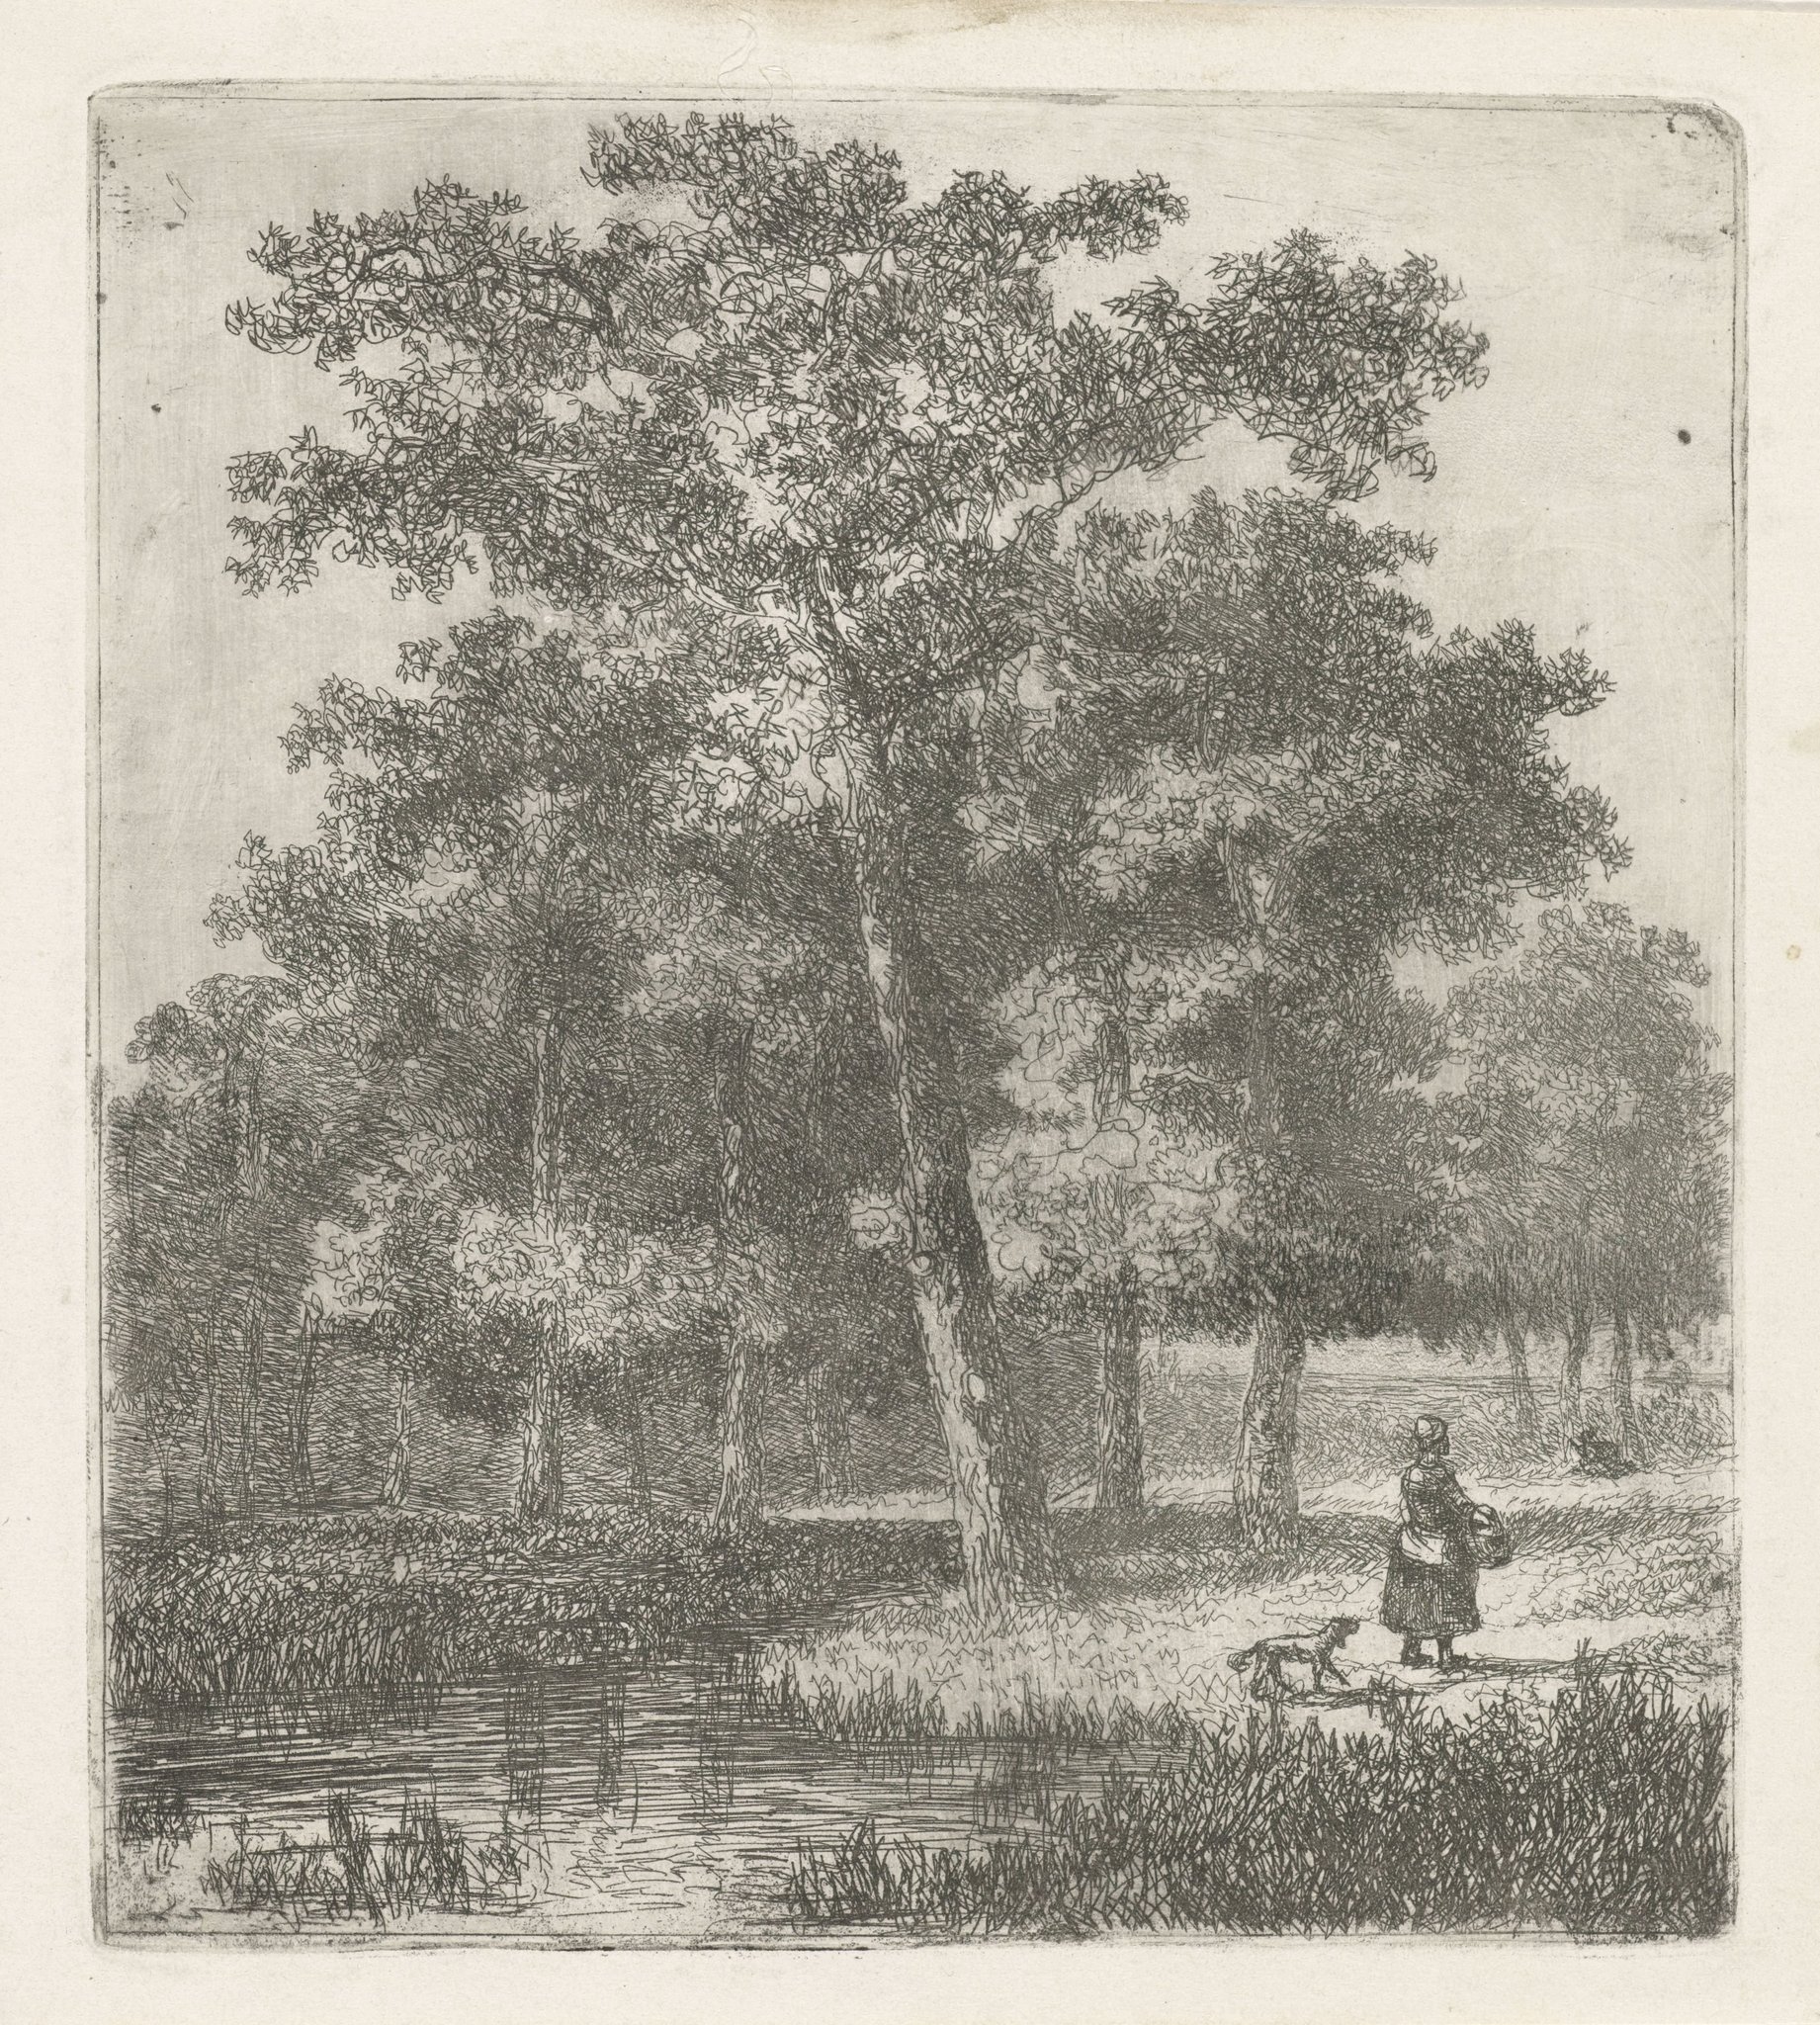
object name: print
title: Bosgezicht met een vrouw en een hond bij een meertje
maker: hermanus jan hendrik van rijkelijkhuysen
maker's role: painter, print maker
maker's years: 1813-1883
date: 1823-1883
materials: paper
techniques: drypoint, etching, intaglio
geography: utrecht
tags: adult woman, forest, wood, pond, pool, dog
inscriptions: collector's mark: Lugt 2228